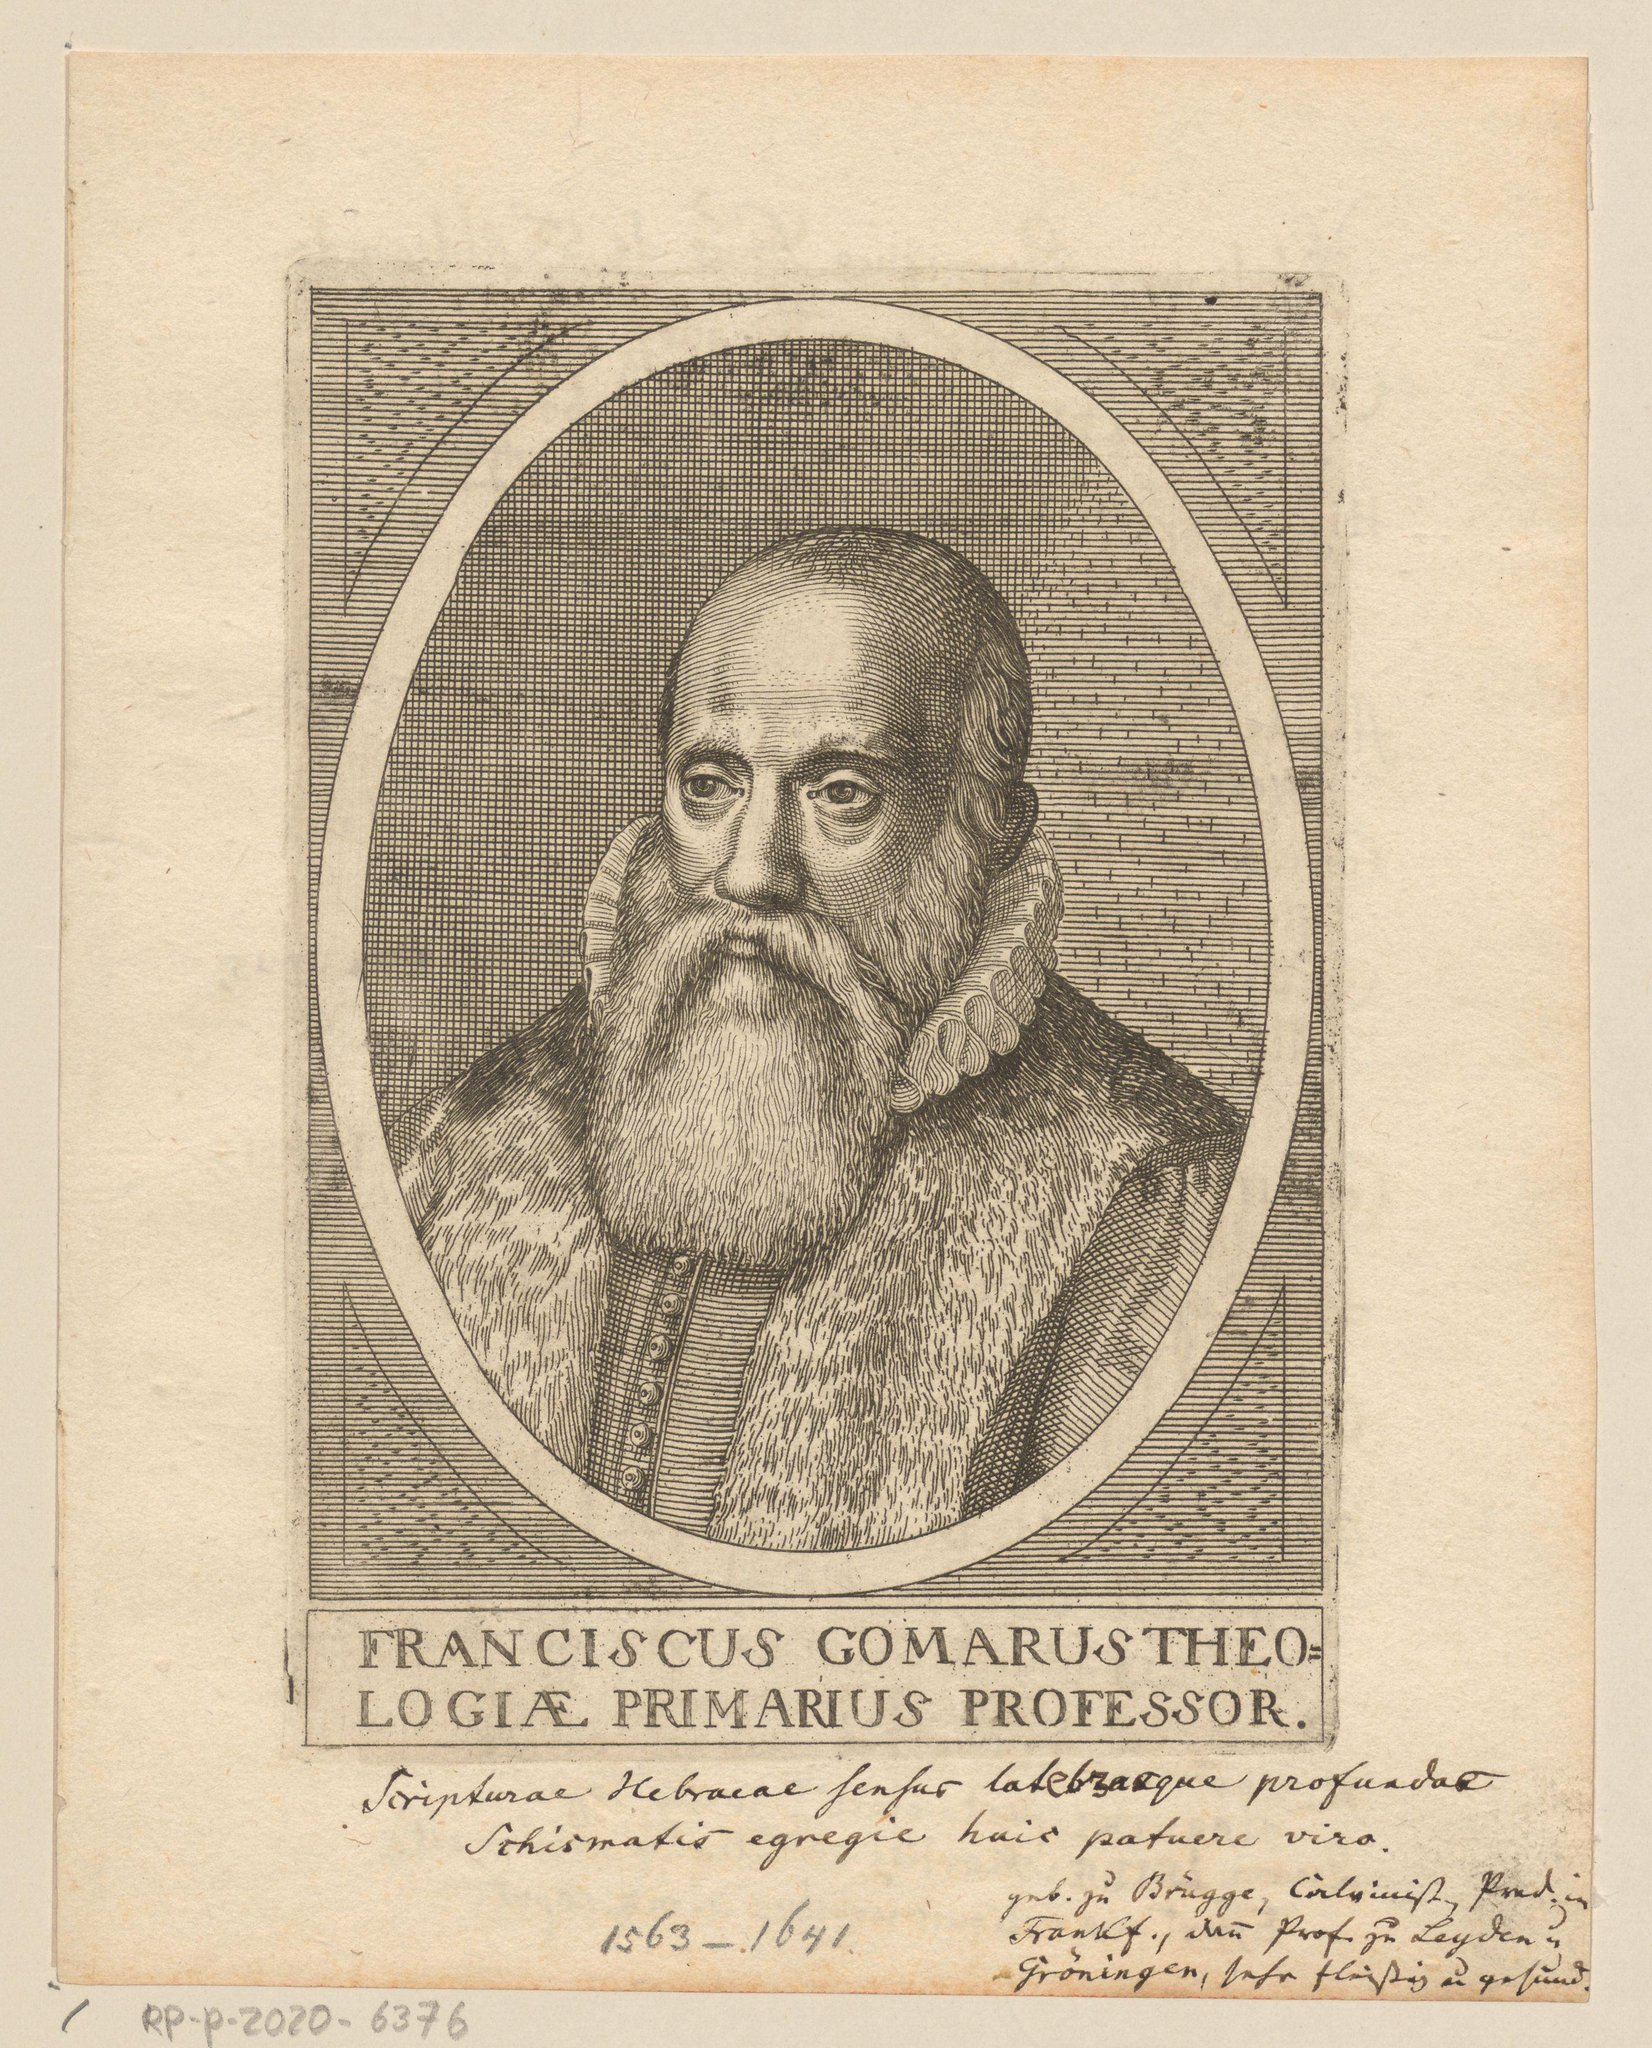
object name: print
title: Portret van Franciscus Gomarus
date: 1674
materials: paper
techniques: engraving, etching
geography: amsterdam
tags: bruges, historical persons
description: Prent uit: Brandt, Geeraert. Historie der Reformatie. Amsterdam: Jan Rieuwertsz, 1674.